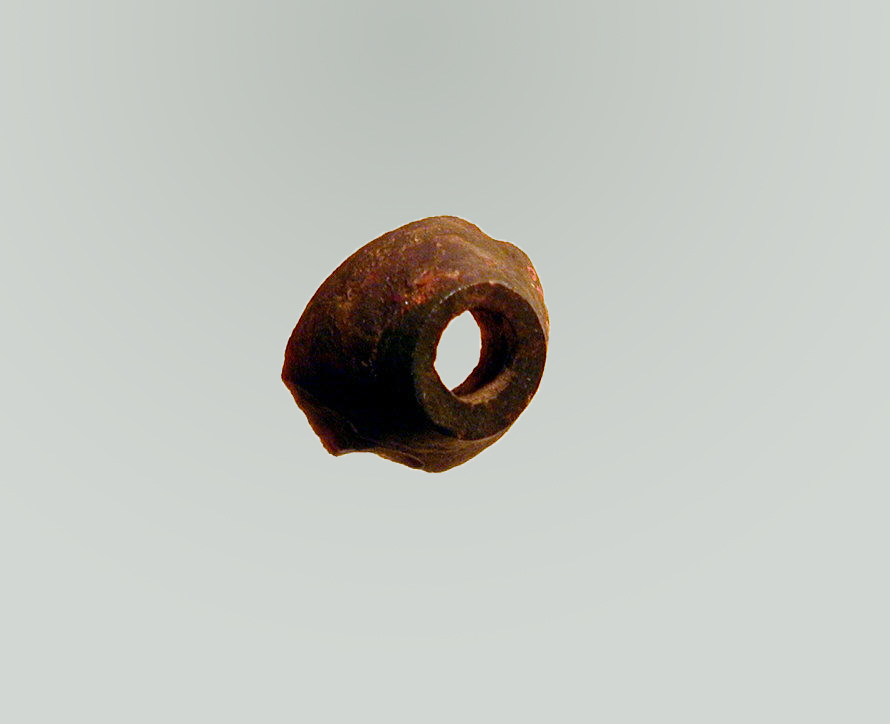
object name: fibula, fragment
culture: etruscan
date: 700-501 BCE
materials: amber